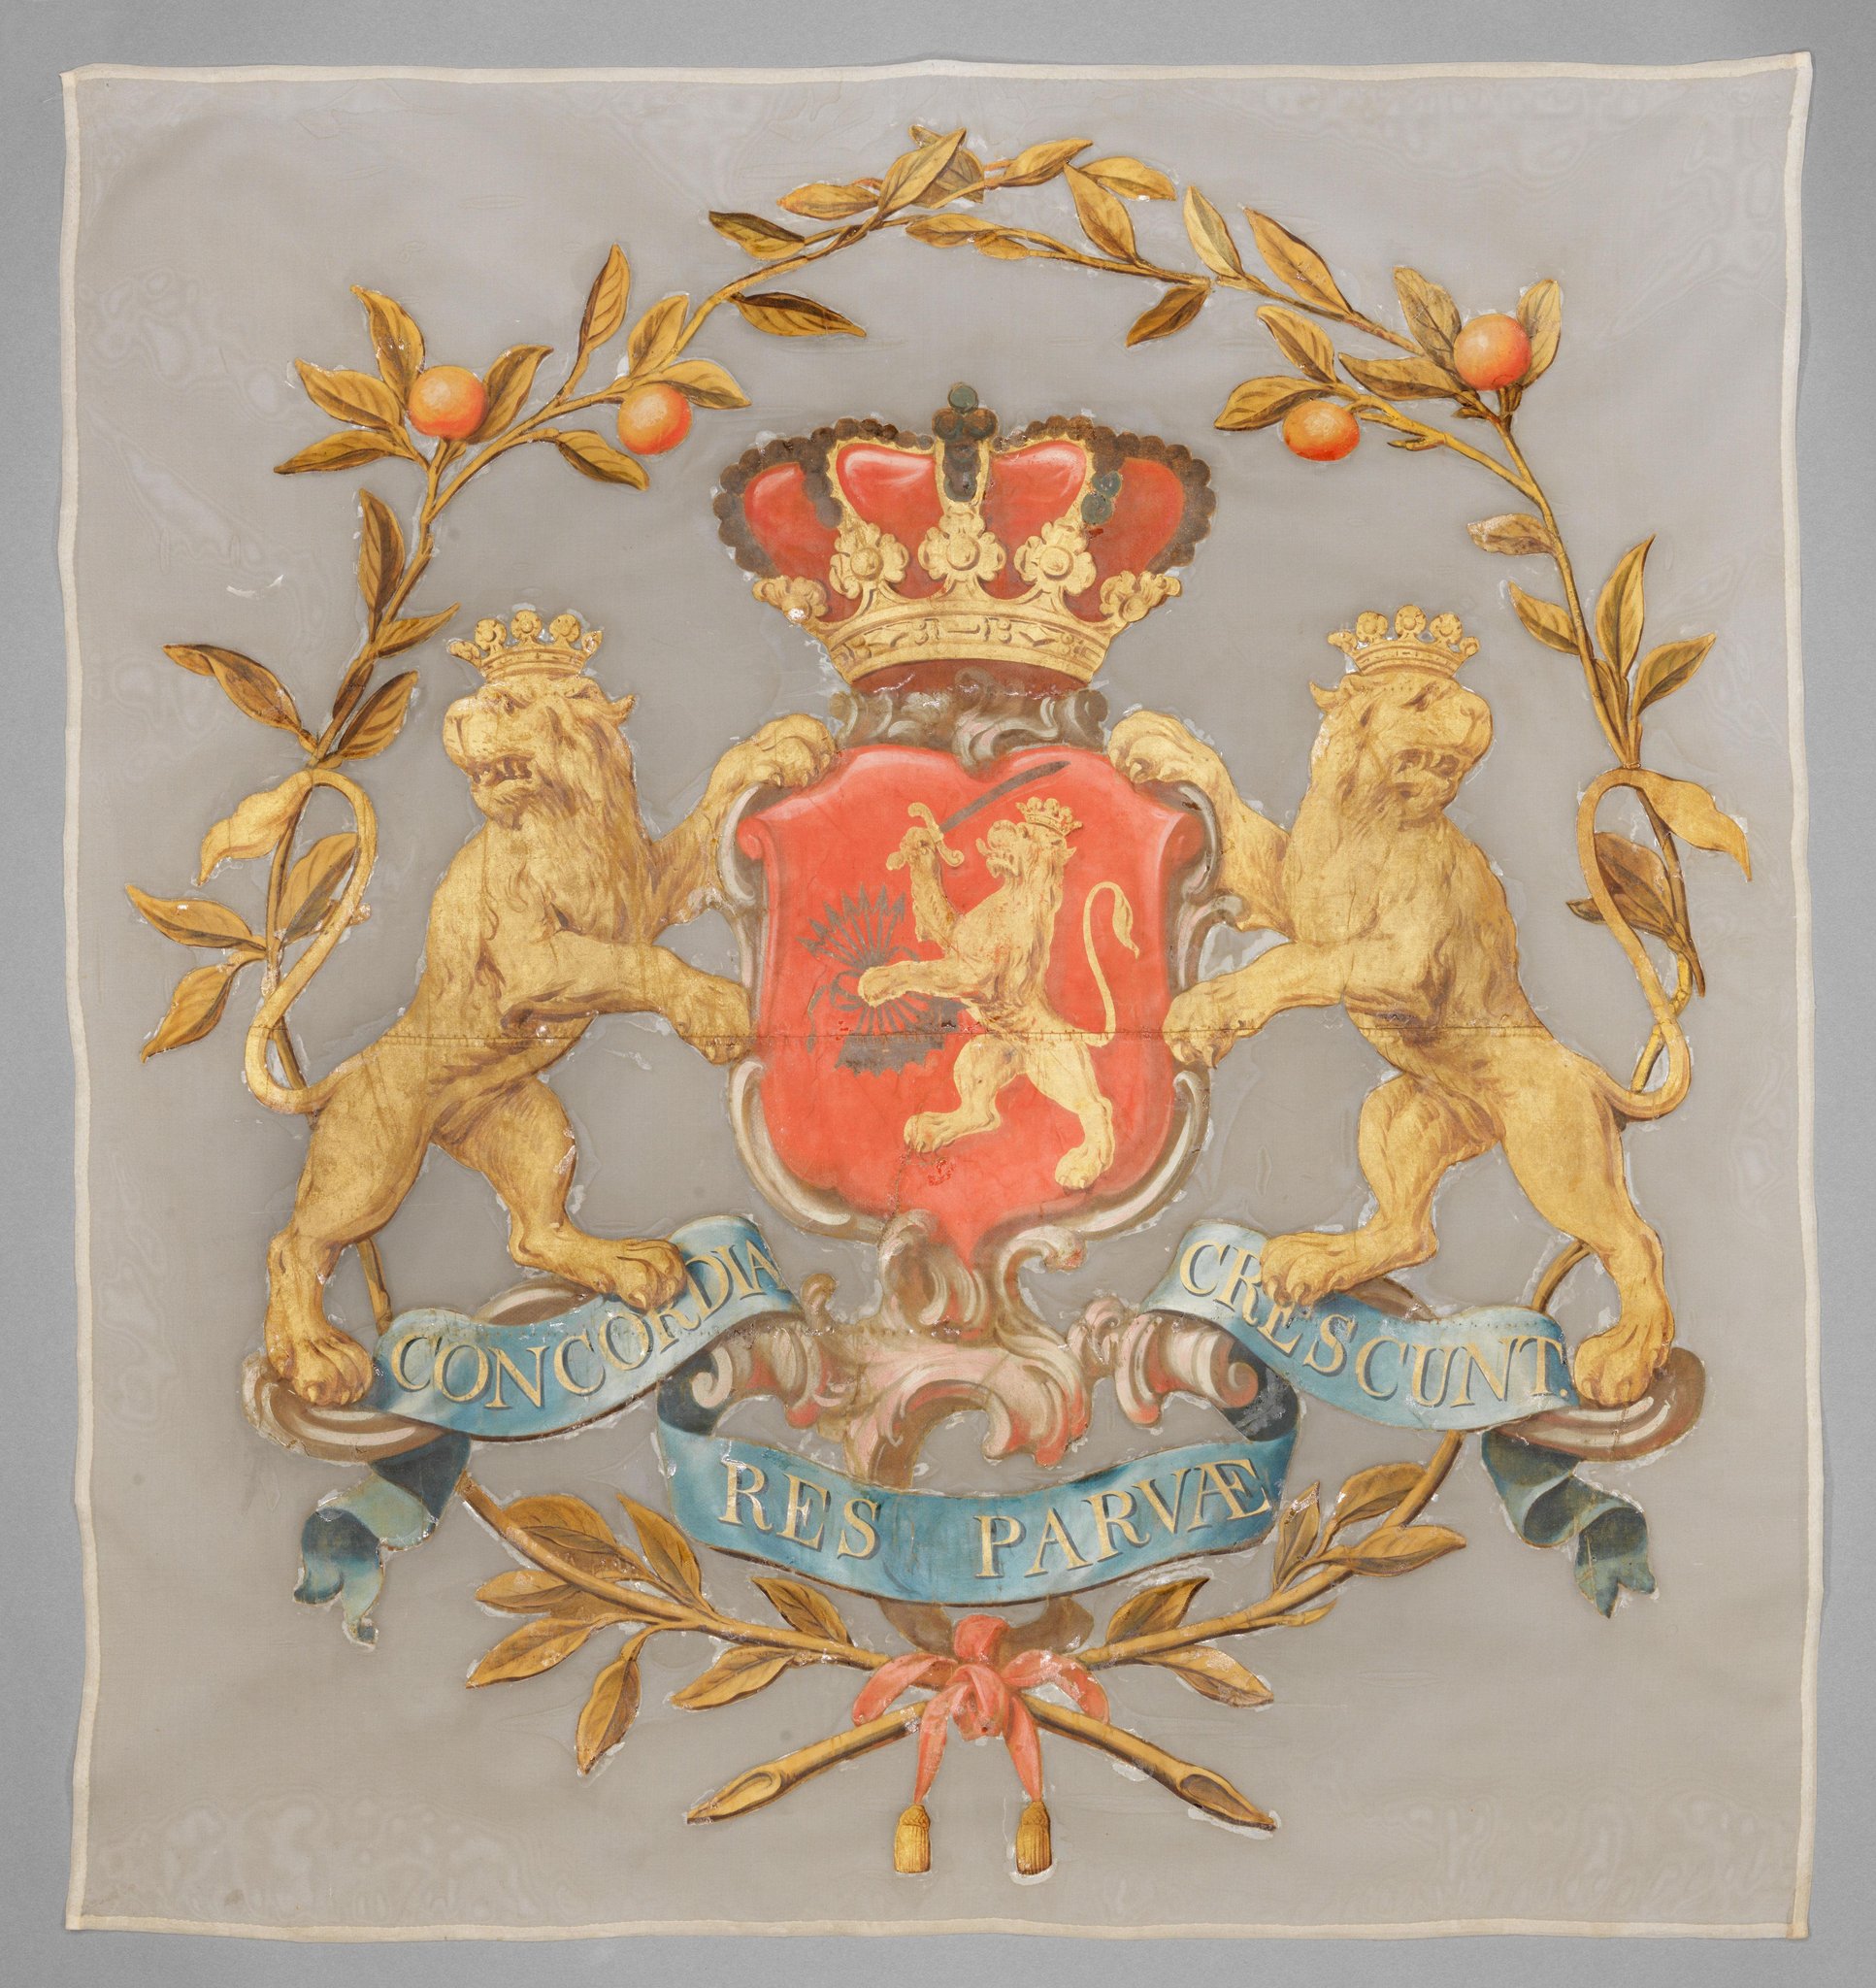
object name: banner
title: Vaandel van een der regimenten van Oranje-Nassau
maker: Anonymous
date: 1752-1795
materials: silk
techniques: lining, painted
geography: netherlands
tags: holland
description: Ecru, op het midden het wapen der Republiek, gehouden door twee omziende leeuwen met een hertogelijke kroon, het wapen gedekt met een koningskroon. Het schild is gevat in een asymmetrische cartouche waaronder een banderol met in klassieke gouden kapitalen: CONCORDIA RES PARVAE CRESCUNT, de spreuk der Republiek. Het geheel is omgeven door twee omhoog gebogen gouden takken met oranjeappels, welke aan de onderzijde door een kleine oranjerode strik bijeengehouden worden. Paradekant identiek.